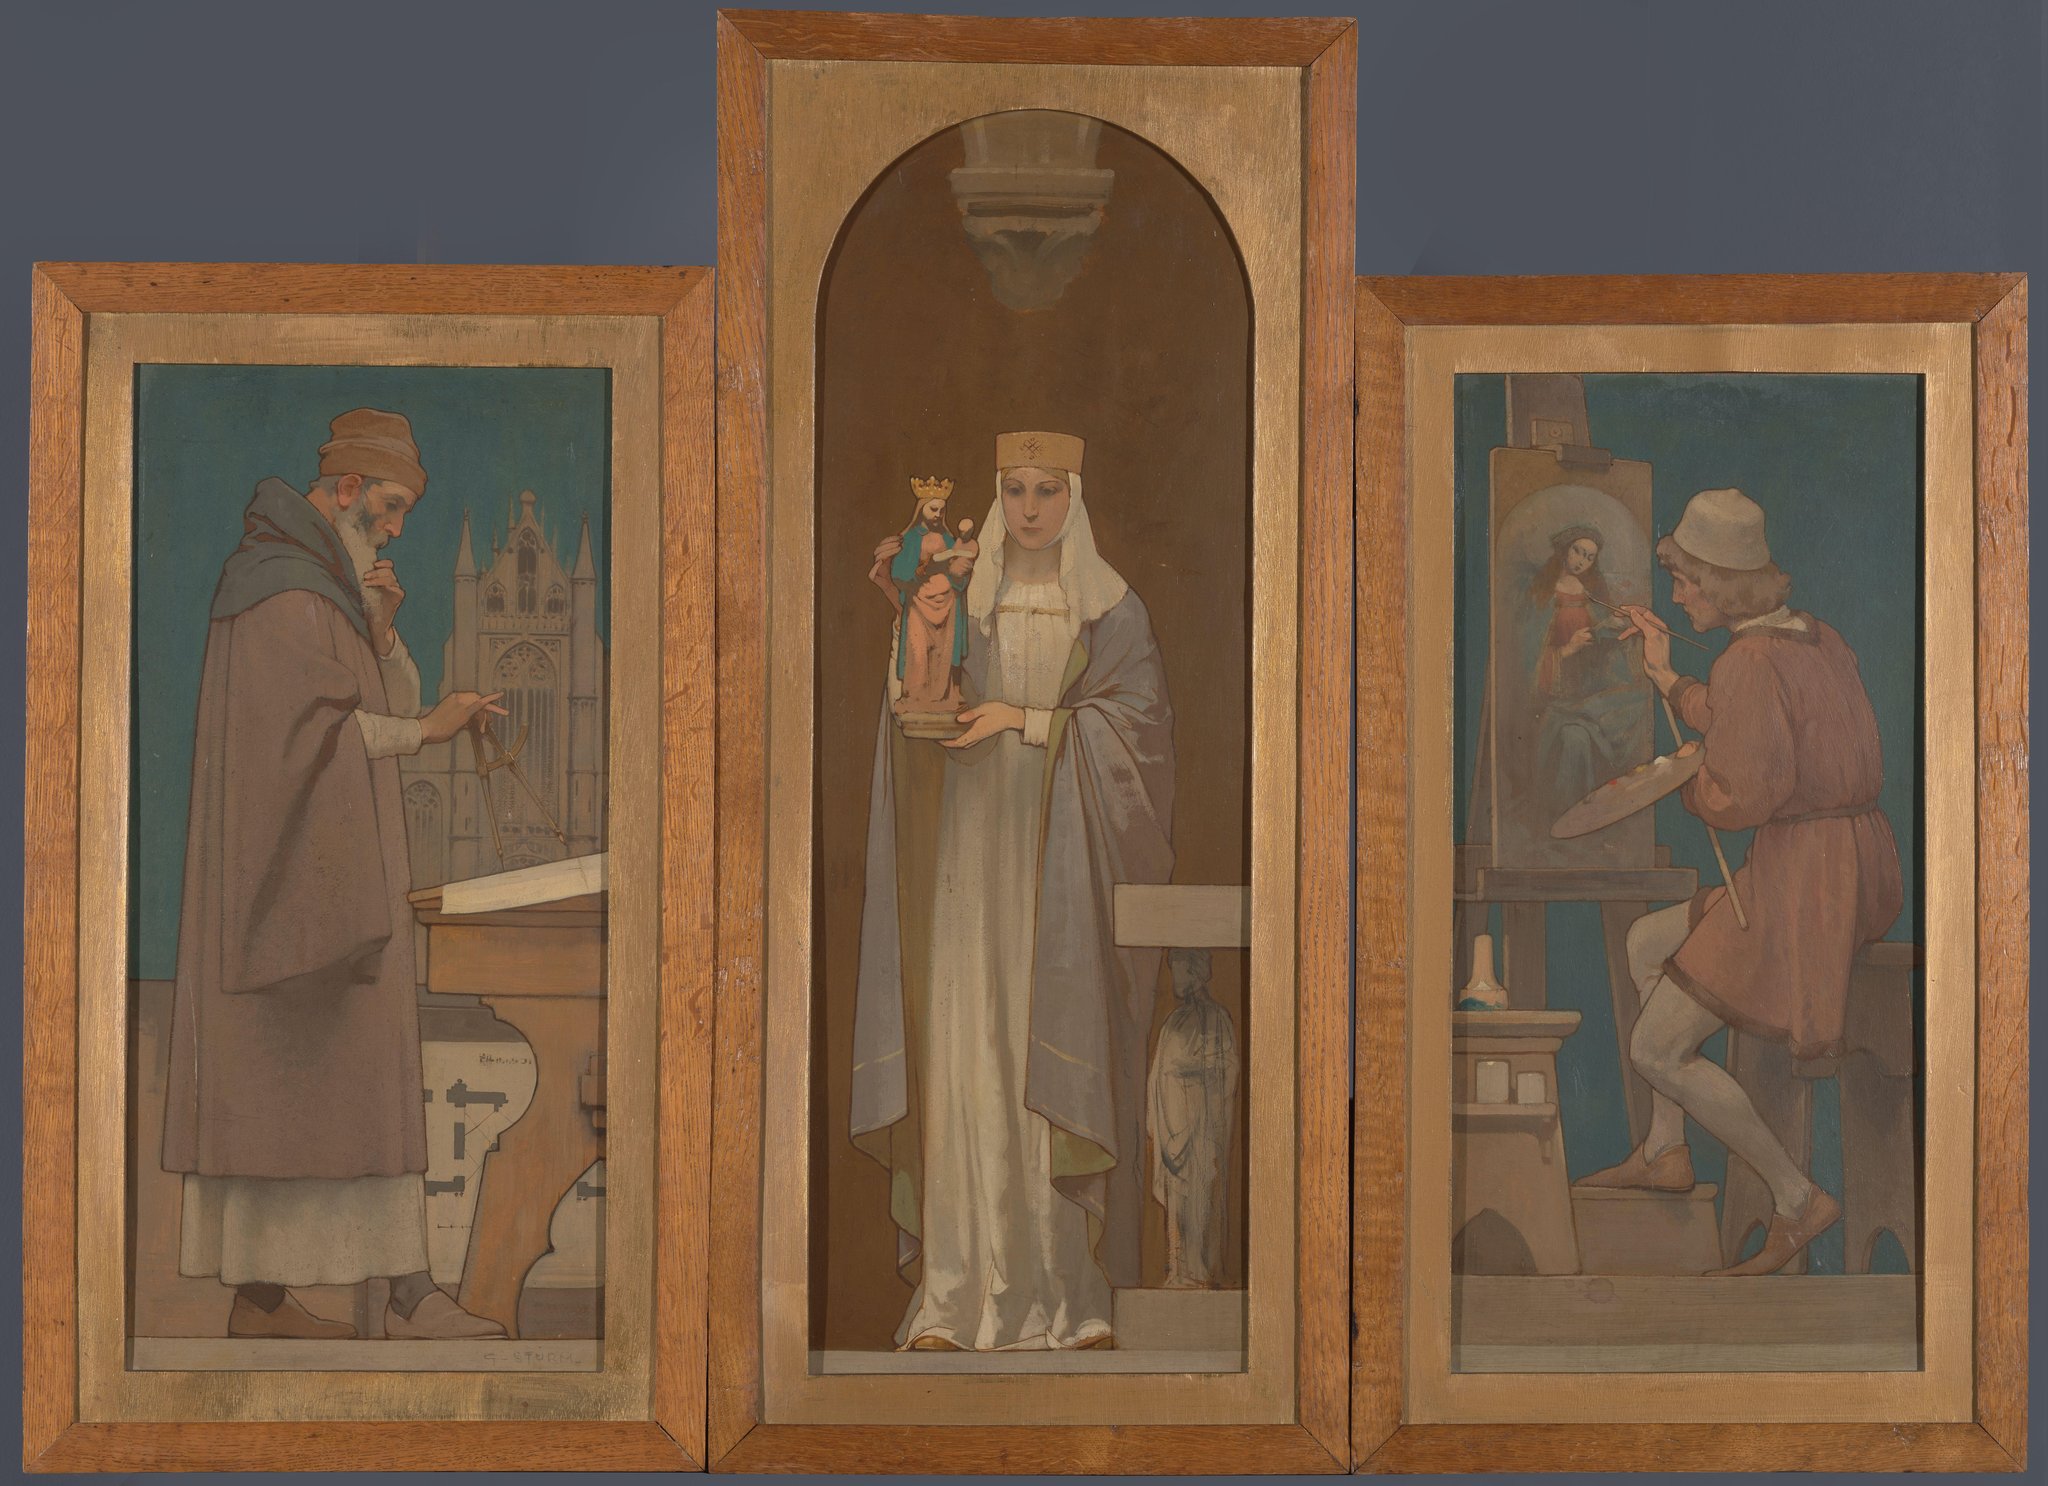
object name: triptych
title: Architectuur- Sculptuur - Schilderkunst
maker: georg sturm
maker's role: draughtsman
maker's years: 1855-1923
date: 1876-1885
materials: oil, paint, paper, wood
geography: amsterdam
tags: rijksmuseum amsterdam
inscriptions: signature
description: Drie voorstudies van de wandschilderingen in de Eregalerij van het Rijksmuseum, gecombineerd tot een drieluik.